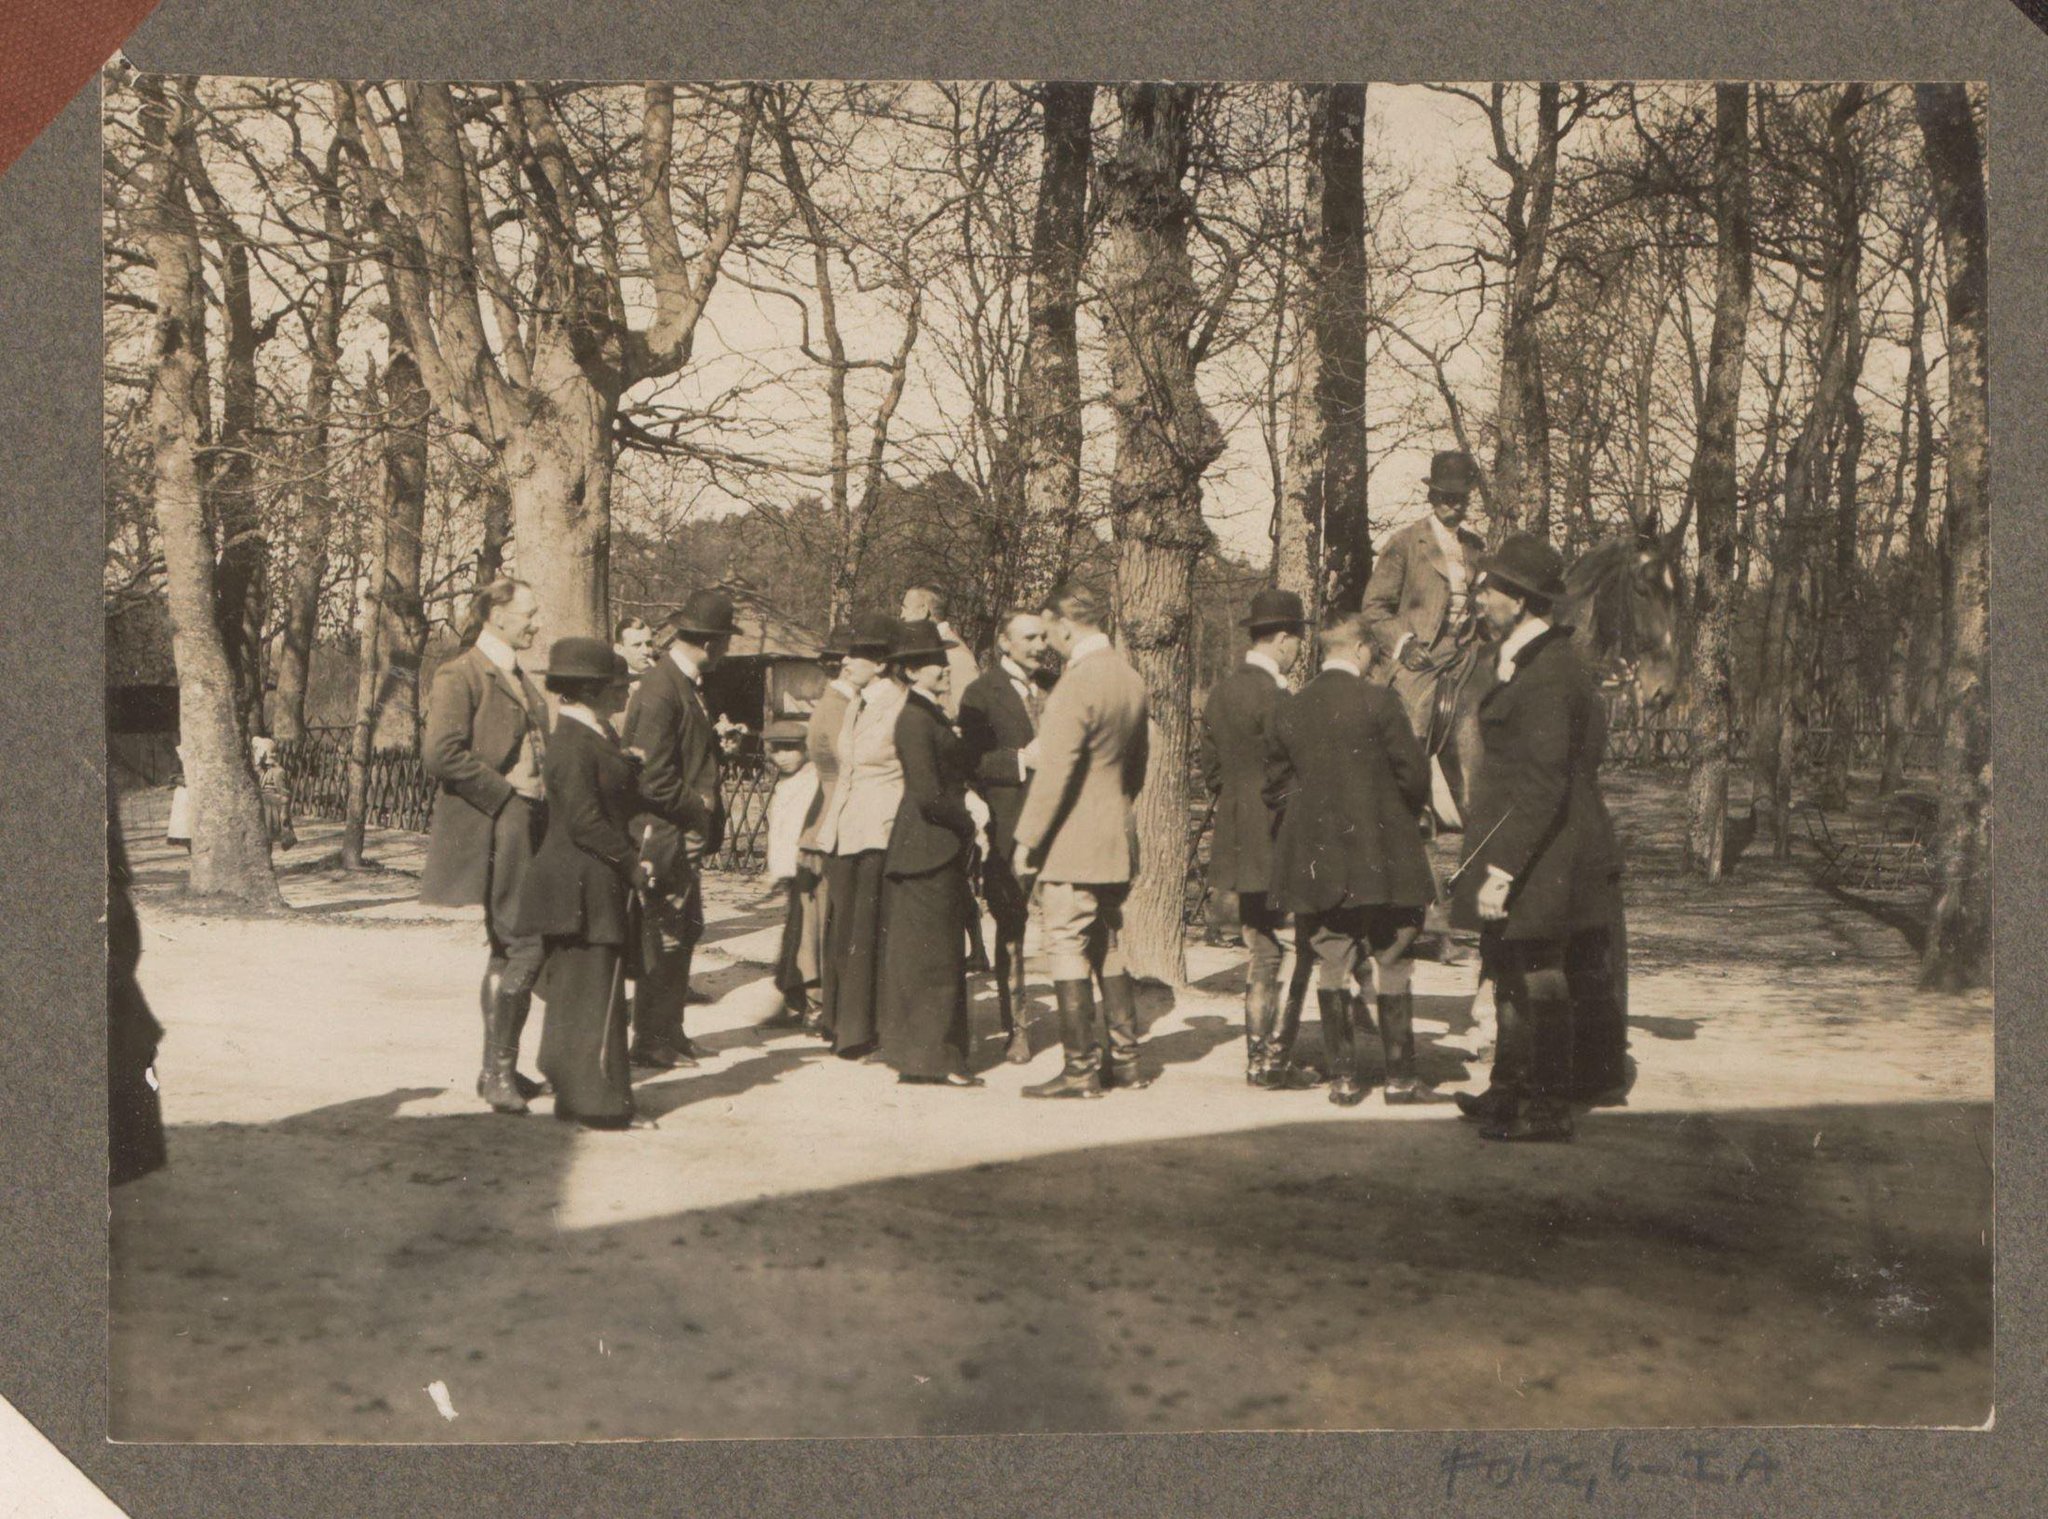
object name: photograph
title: Ruitertafereel op Koninklijke Houtvesterij Het Loo: publiek in een bos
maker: Anonymous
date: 1900-1925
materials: photographic support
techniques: gelatin silver print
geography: het loo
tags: hunting, chase, hunting-ground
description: Onderdeel van Fotoalbum van de heer Brams, opperhoutvester van koningin Wilhelmina op Koninklijke Houtvesterij Het Loo.